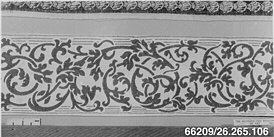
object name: border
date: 1801-1833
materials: cotton